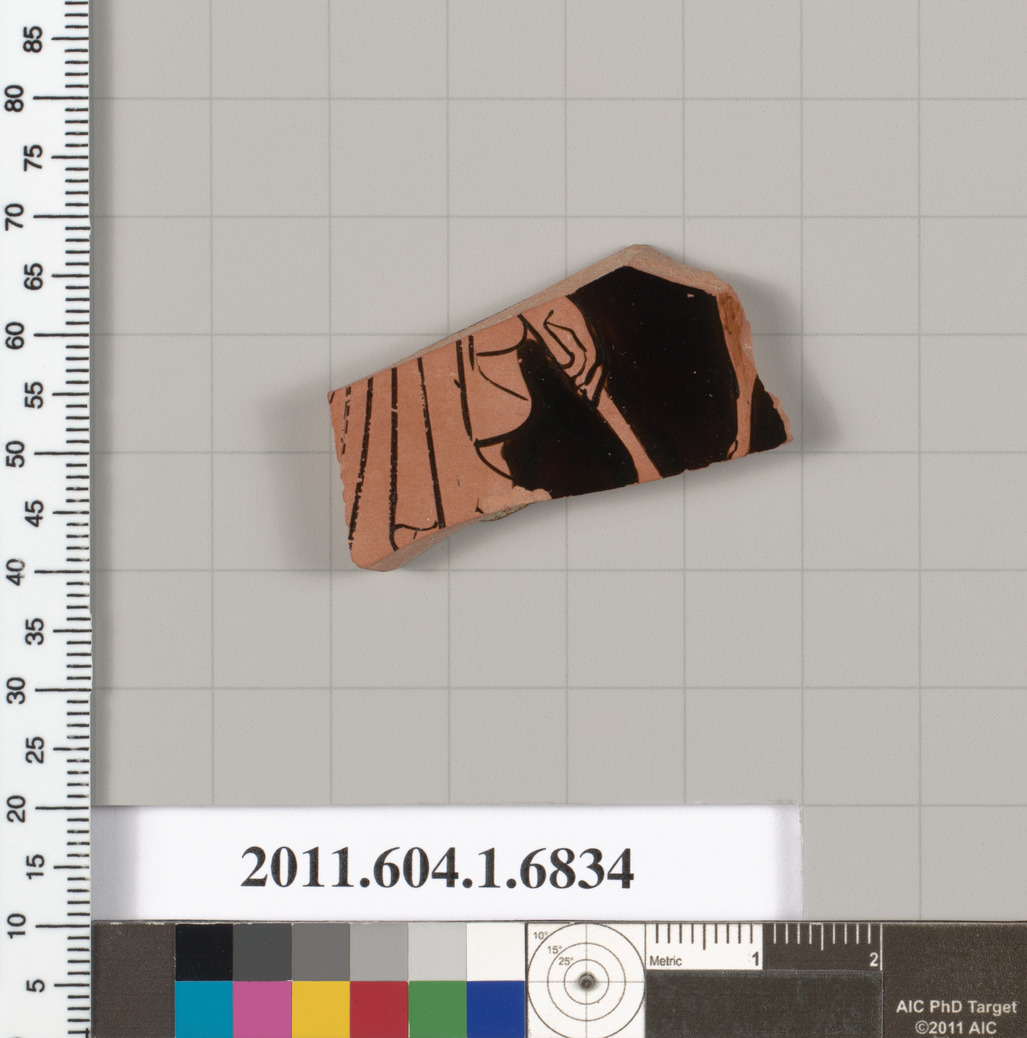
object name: kylix fragment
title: Terracotta fragment of a kylix (drinking cup)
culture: greek, attic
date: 490-470 BCE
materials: terracotta